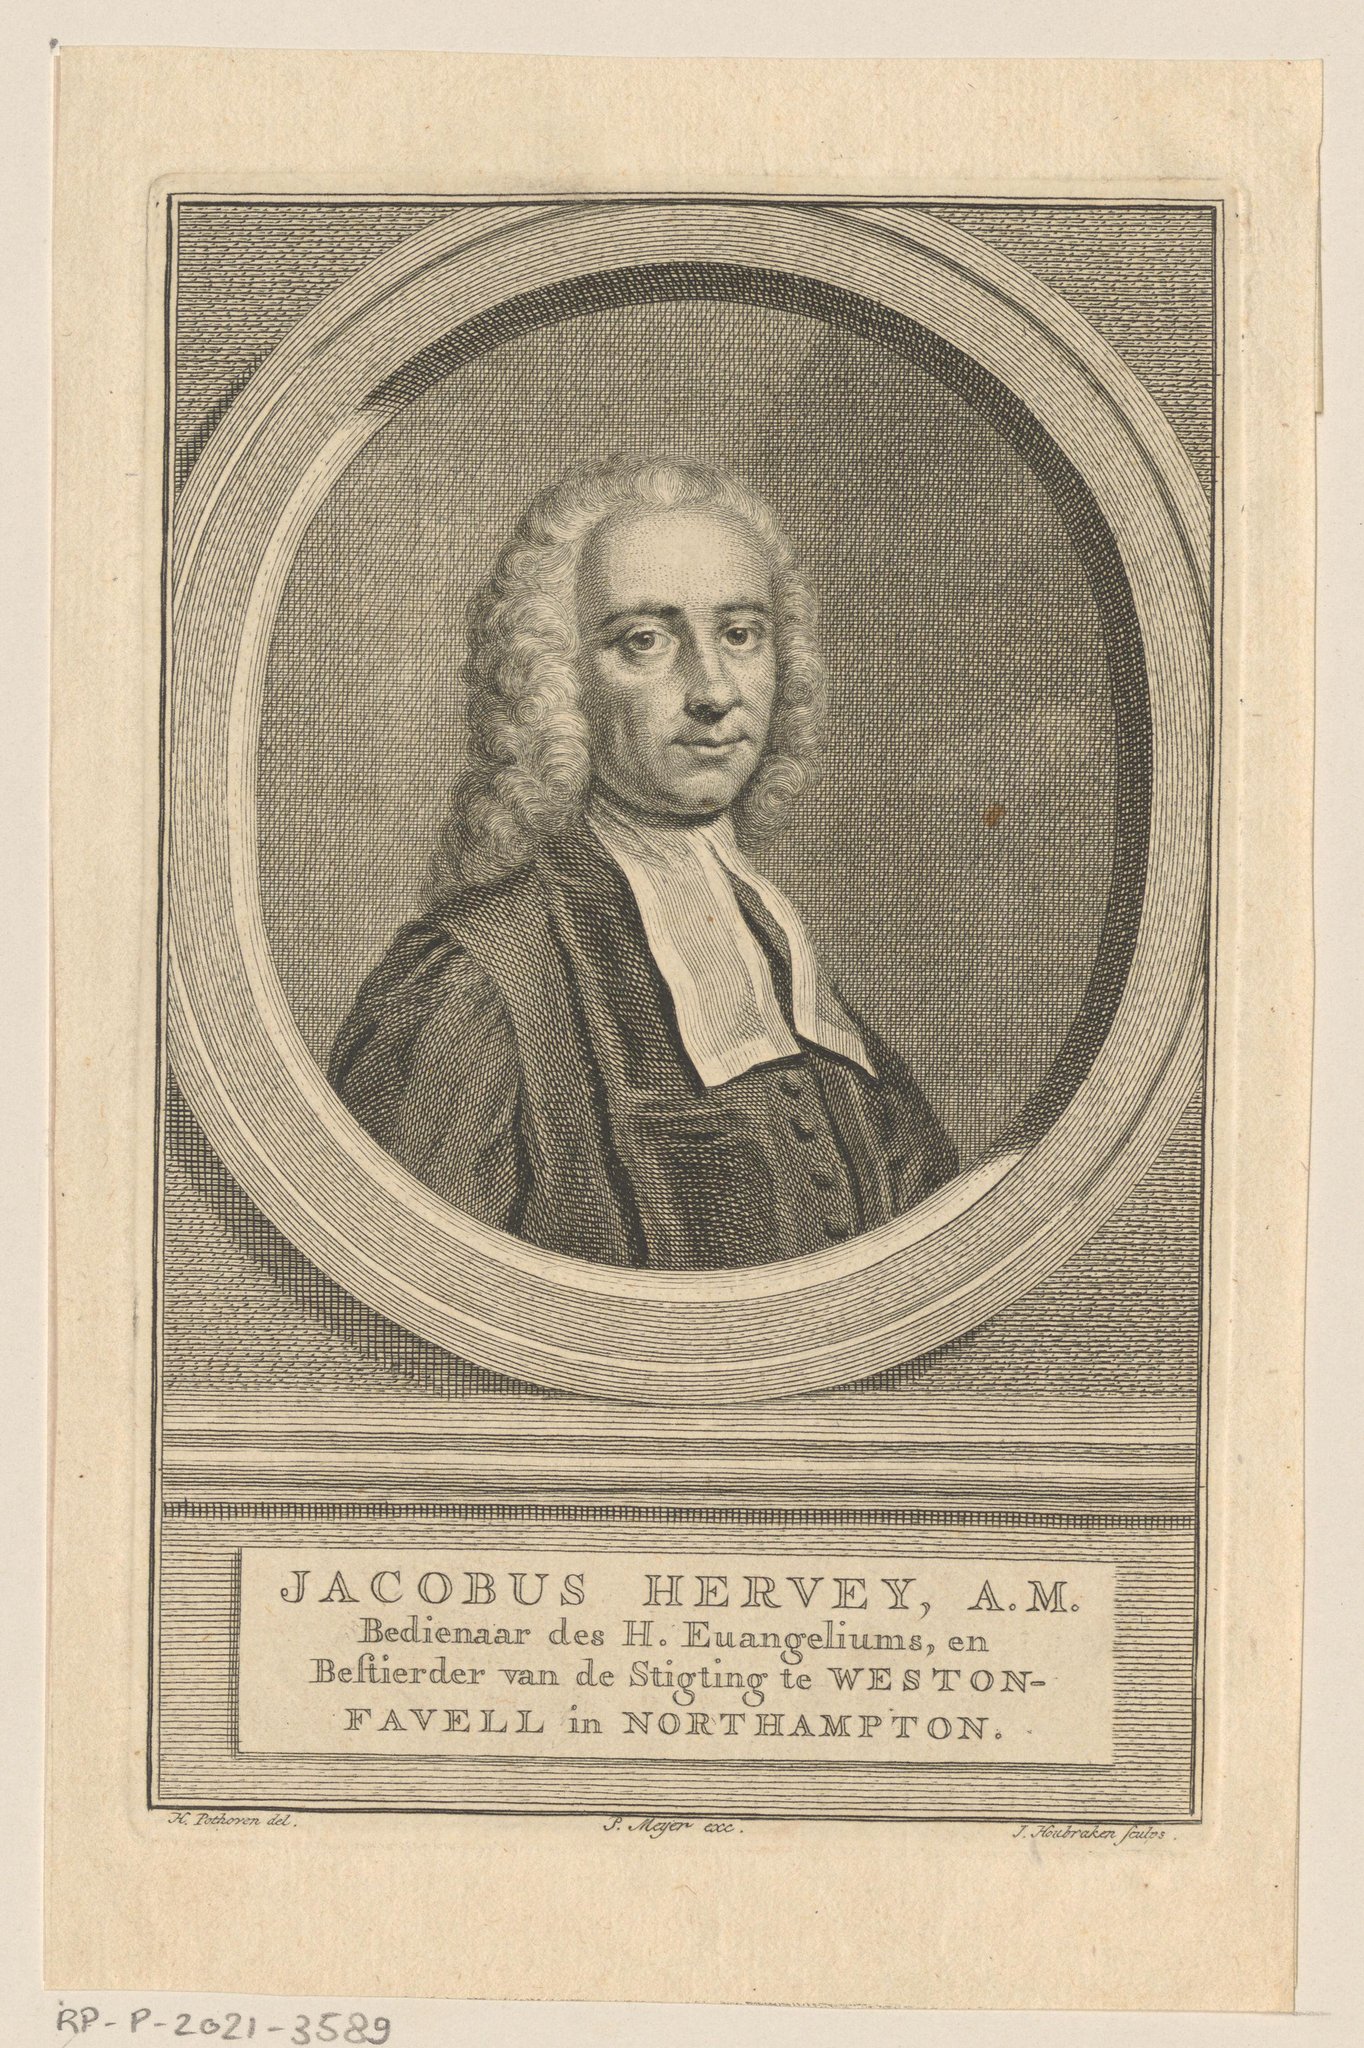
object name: print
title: Portret van James Hervey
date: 1747-1780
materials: paper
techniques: engraving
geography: amsterdam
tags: clergyman, historical persons, portrait of a writer